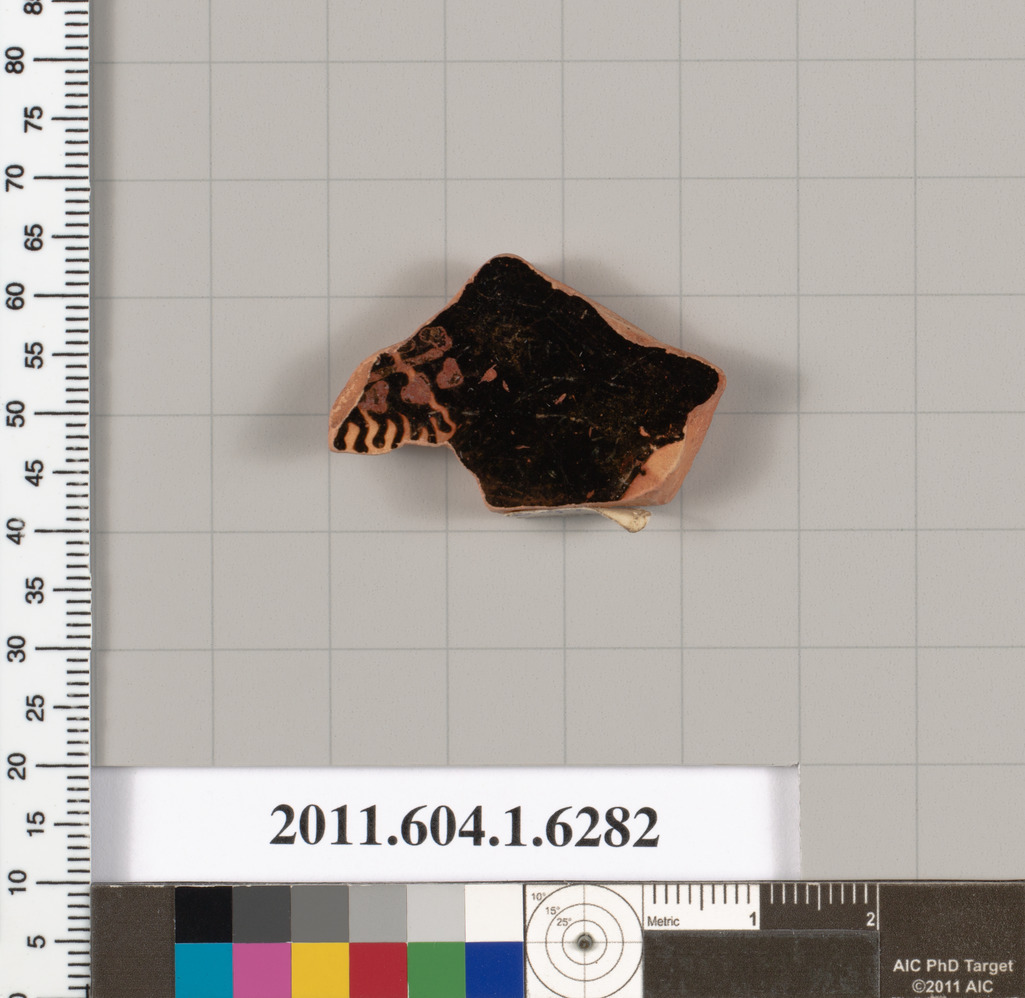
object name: kylix fragment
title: Terracotta fragment of a kylix (drinking cup)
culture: greek, attic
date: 500-480 BCE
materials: terracotta